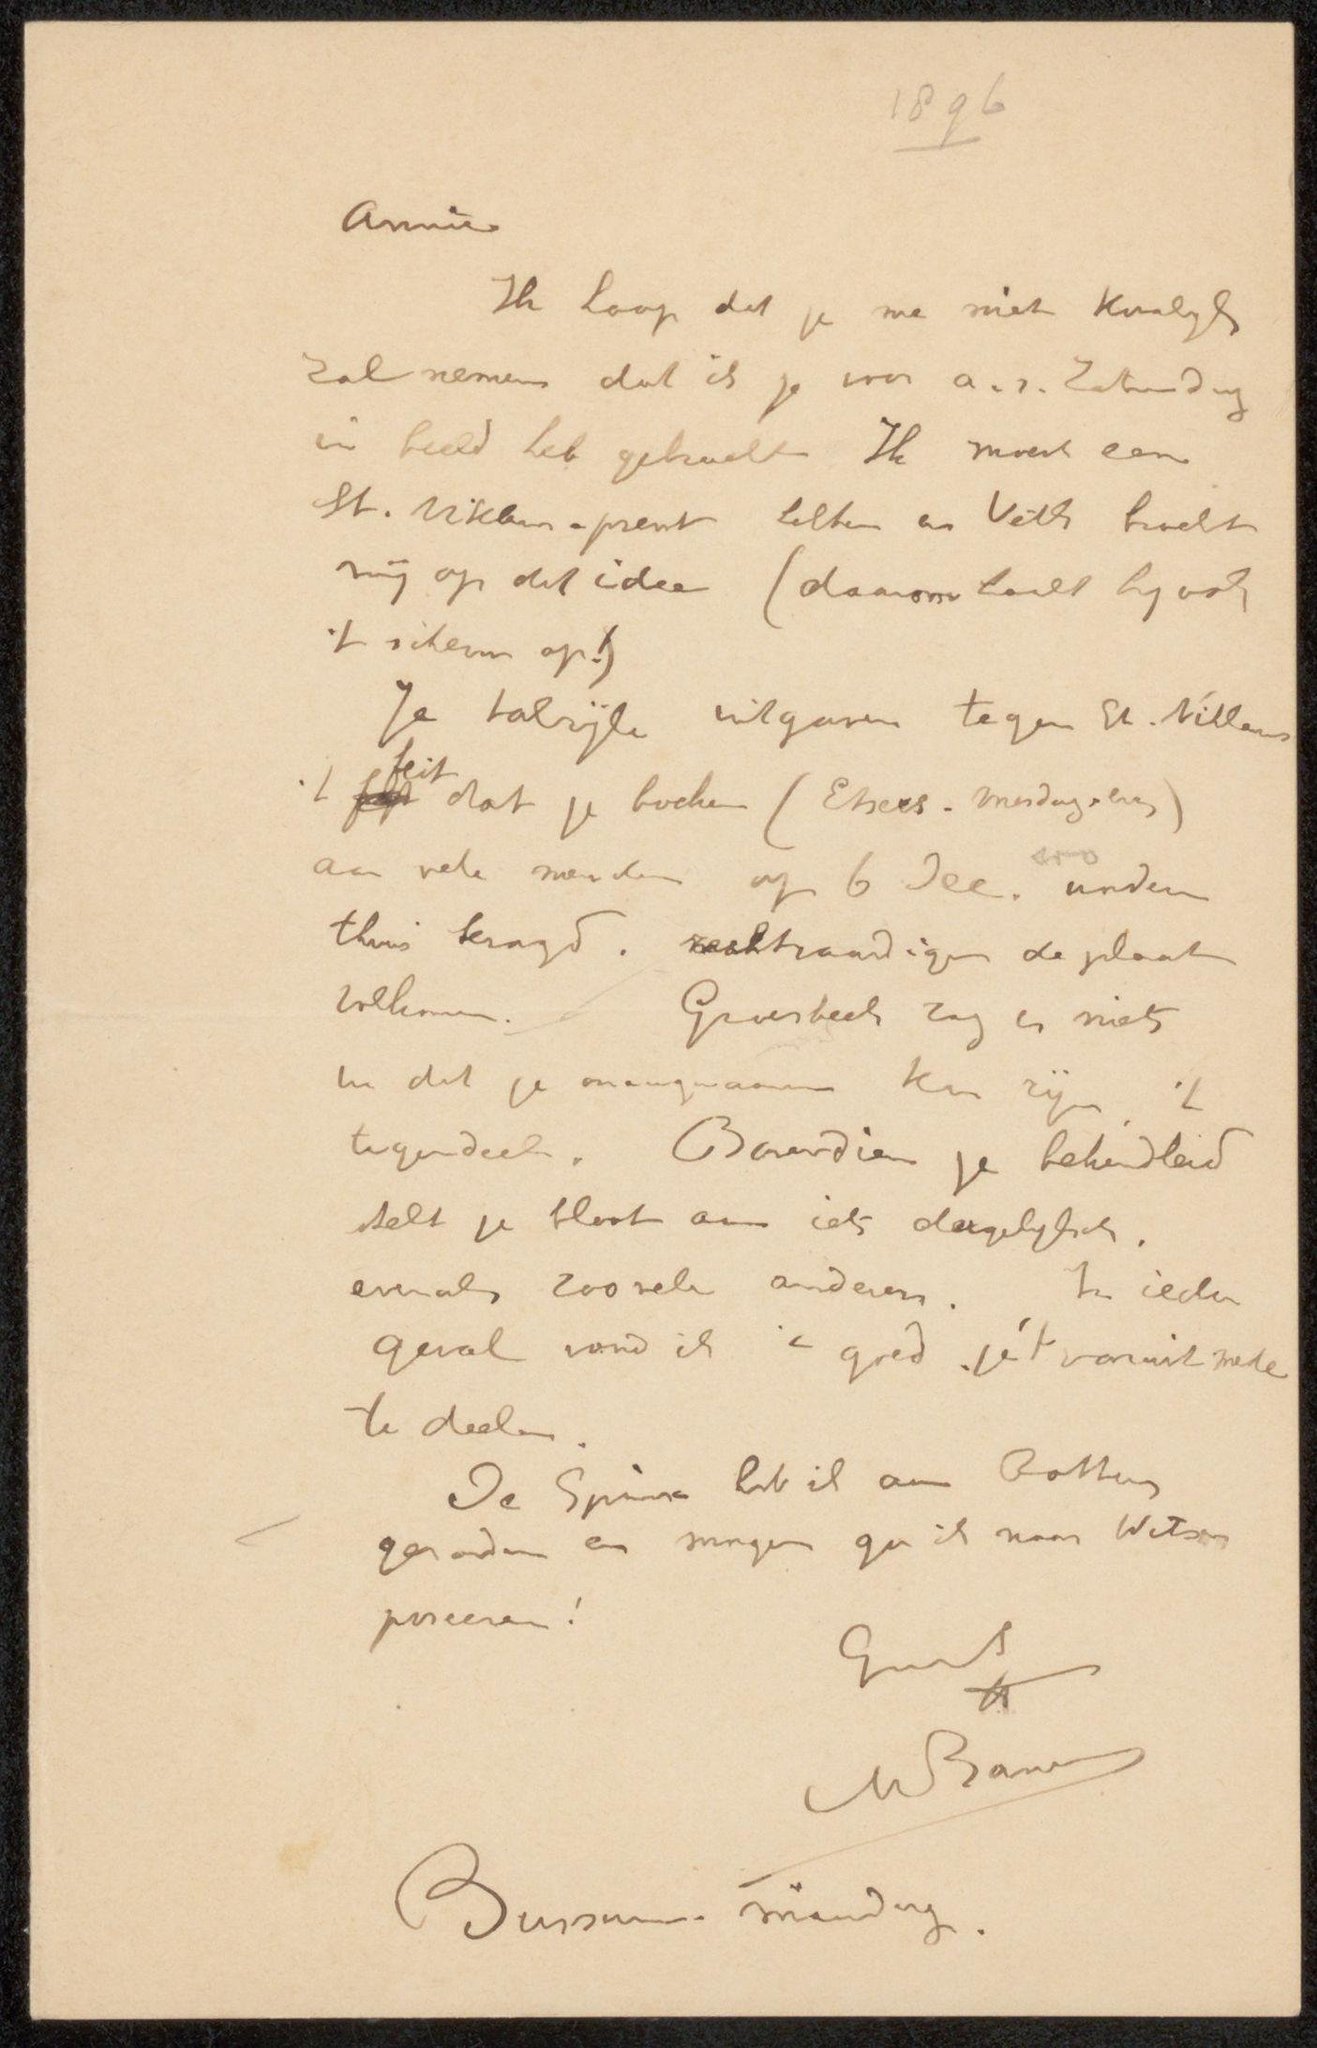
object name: letter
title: Brief aan Philip Zilcken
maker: marius bauer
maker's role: draughtsman, print maker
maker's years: 1867-1932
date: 1877-1932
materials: ink, paper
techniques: pen, writing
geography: bussum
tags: dordrecht, designer, jan veth, amsterdam, painter, print maker, draughtsman, willem witsen, klaas groesbeek, philip zilcken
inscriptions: collector's mark: ‘RPK’